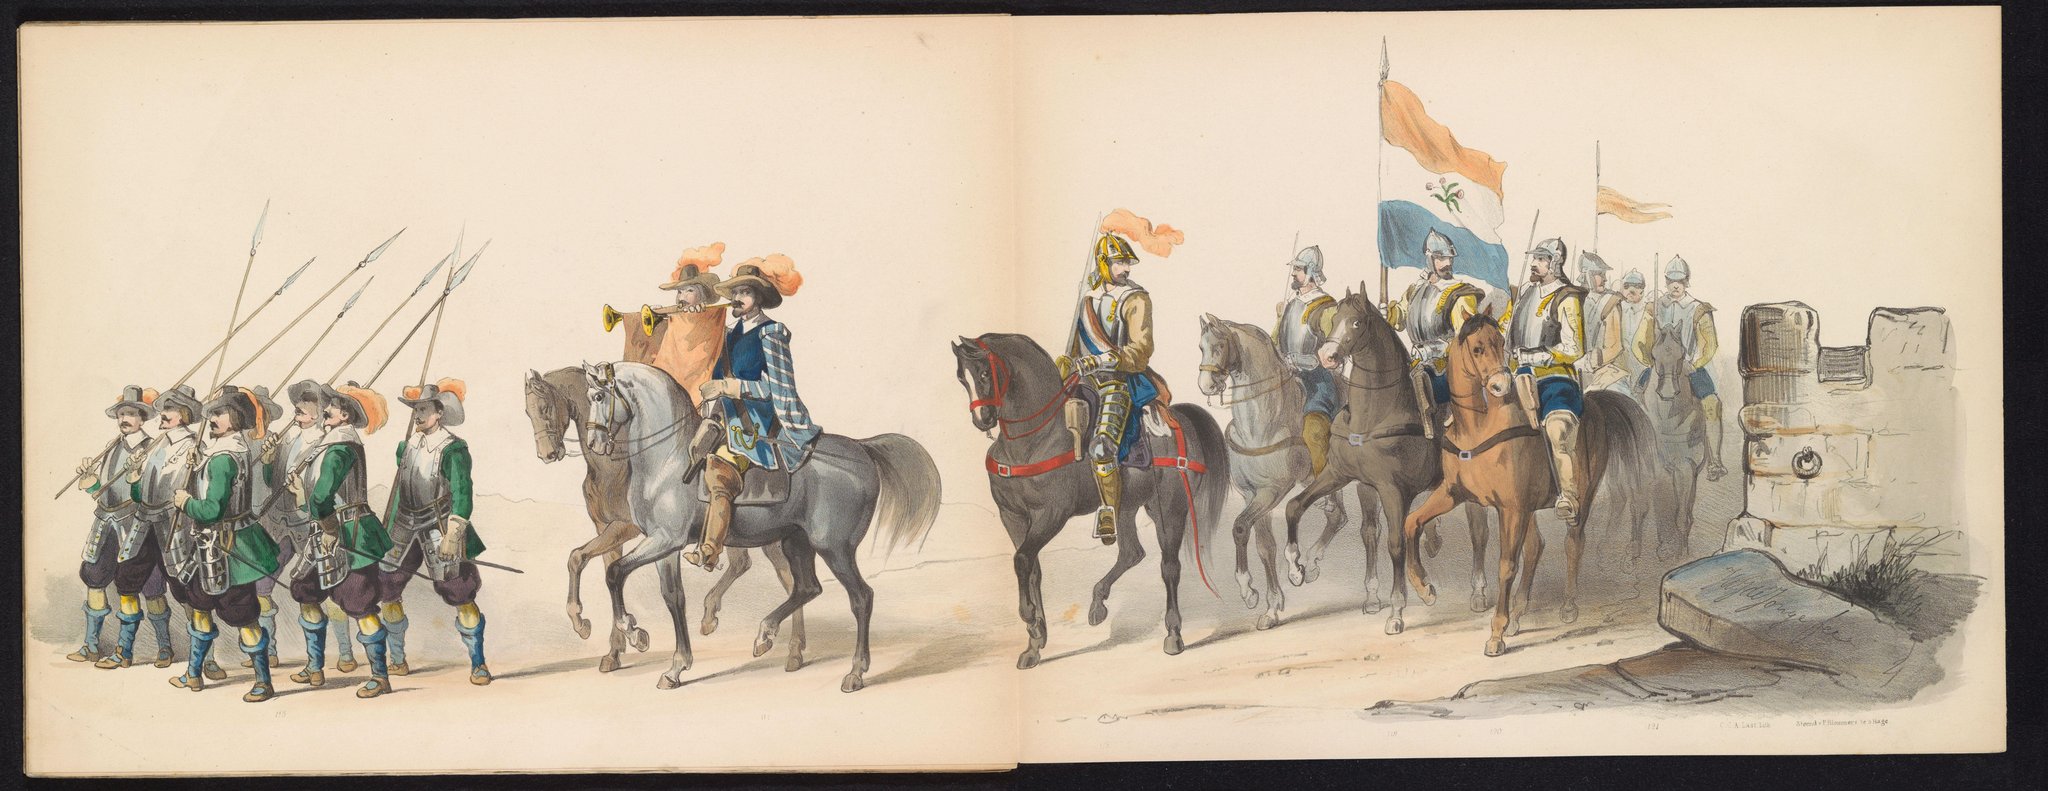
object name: print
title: Intogt van Frederik Hendrik in 's Hertogenbosch in 1629 : gecostumeerde voorstelling door de H.H. studenten der Leydsche Hoogeschool den XI Junij van het jaar 1850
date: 1850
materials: paper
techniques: lithograph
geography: the hague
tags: the hague, frederick henry (prince of orange), students' pageant, costumes used in pageants, leiden, den bosch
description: Historische gekostumeerde optocht van de studenten van de Leidse Hogeschool op 11 juni 1850. De optocht verbeeldt de intocht van Frederik Hendrik te Den Bosch in 1629. Dertiende plaat met de groepen genummerd 109-115. Onderdeel van de serie van dertien aanelkaar geplakte bladen.